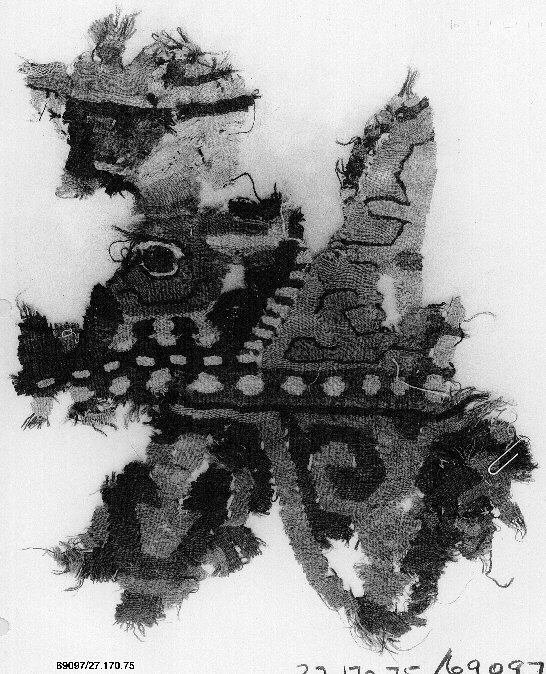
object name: textile fragment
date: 801-1000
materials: wool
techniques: weave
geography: egypt or iraq